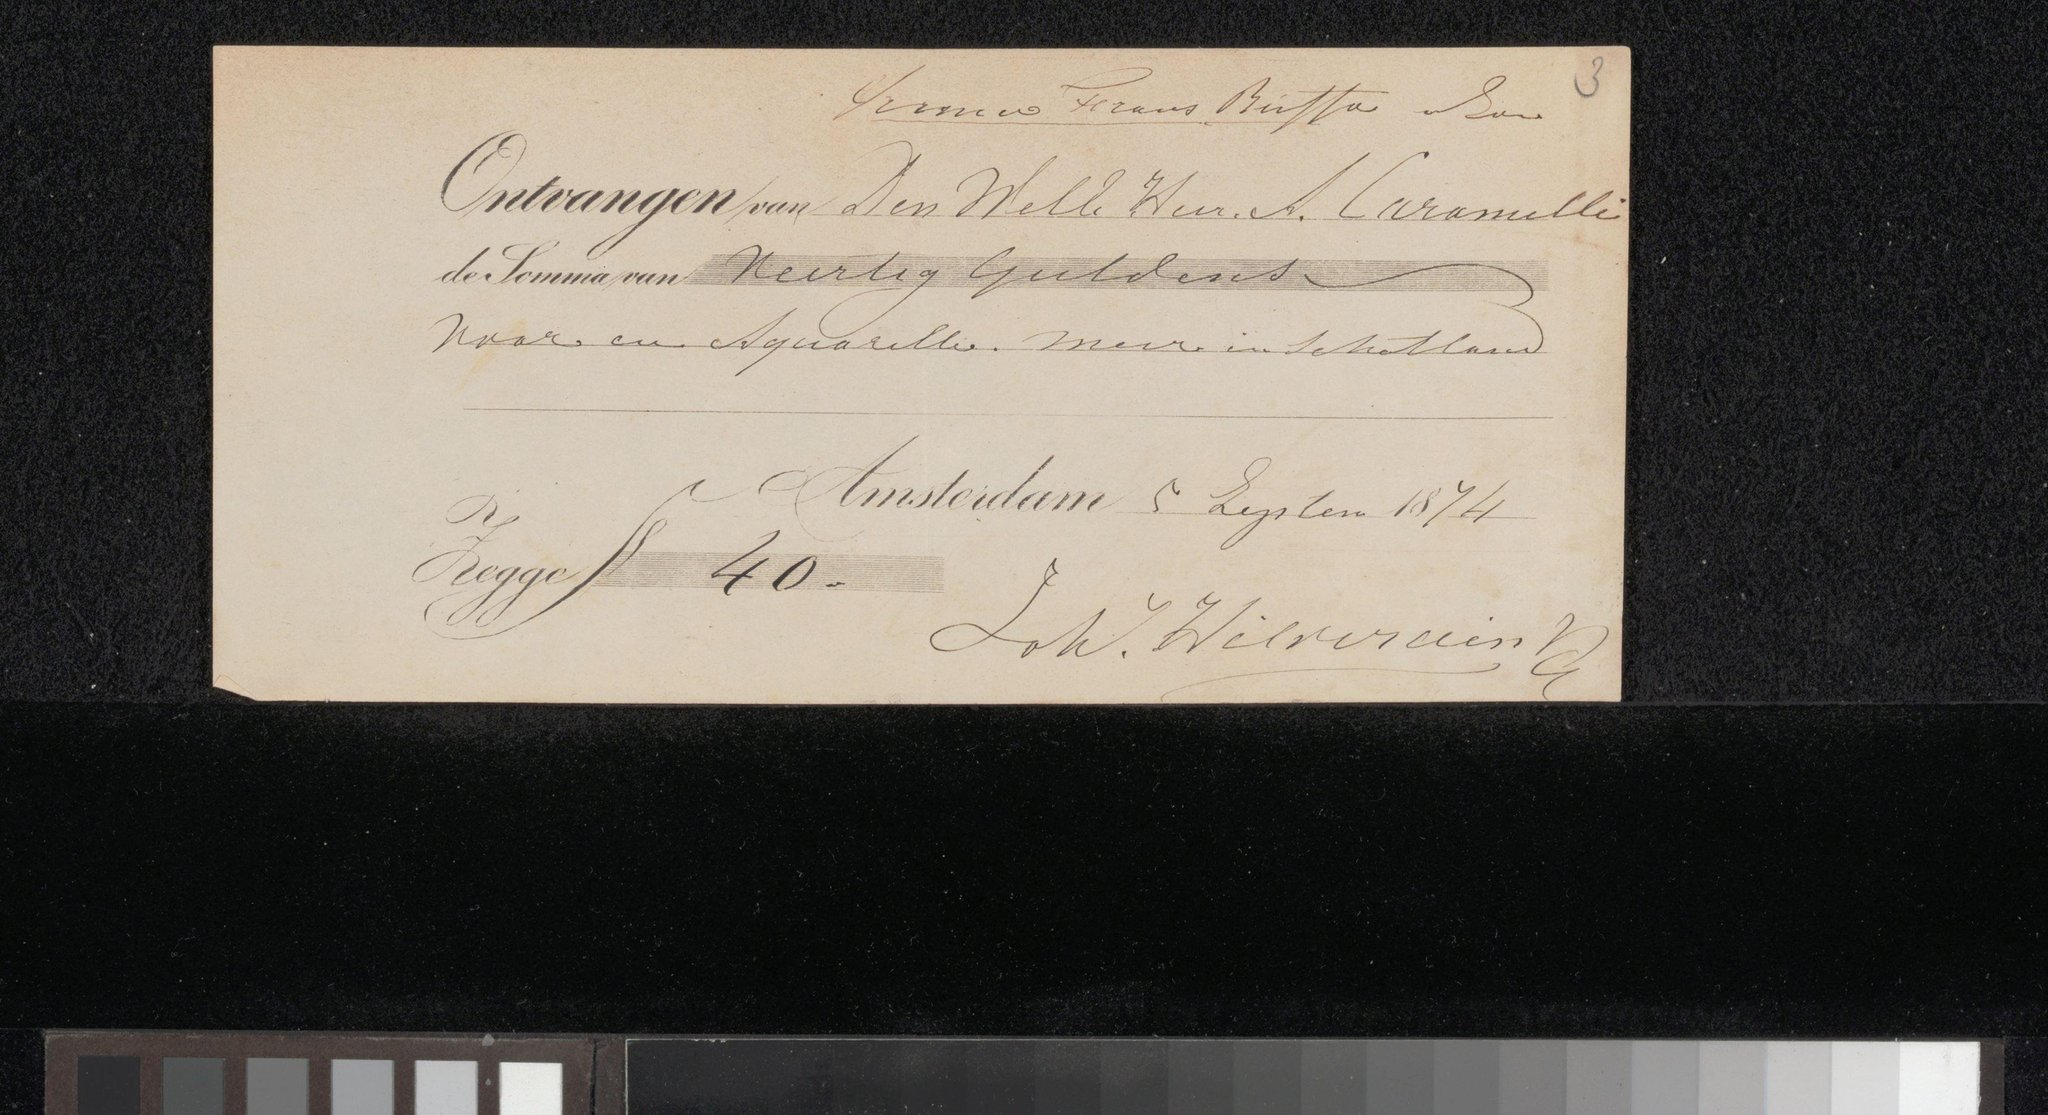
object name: ontvangstbewijs, kwitantie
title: Kwitantie voor Johannes Hilverdink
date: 1874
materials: ink, paper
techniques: pen, printing, writing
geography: amsterdam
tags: amsterdam, painter, print maker, draughtsman, johannes hilverdink, drawing, money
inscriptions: collector's mark: Lugt 2233